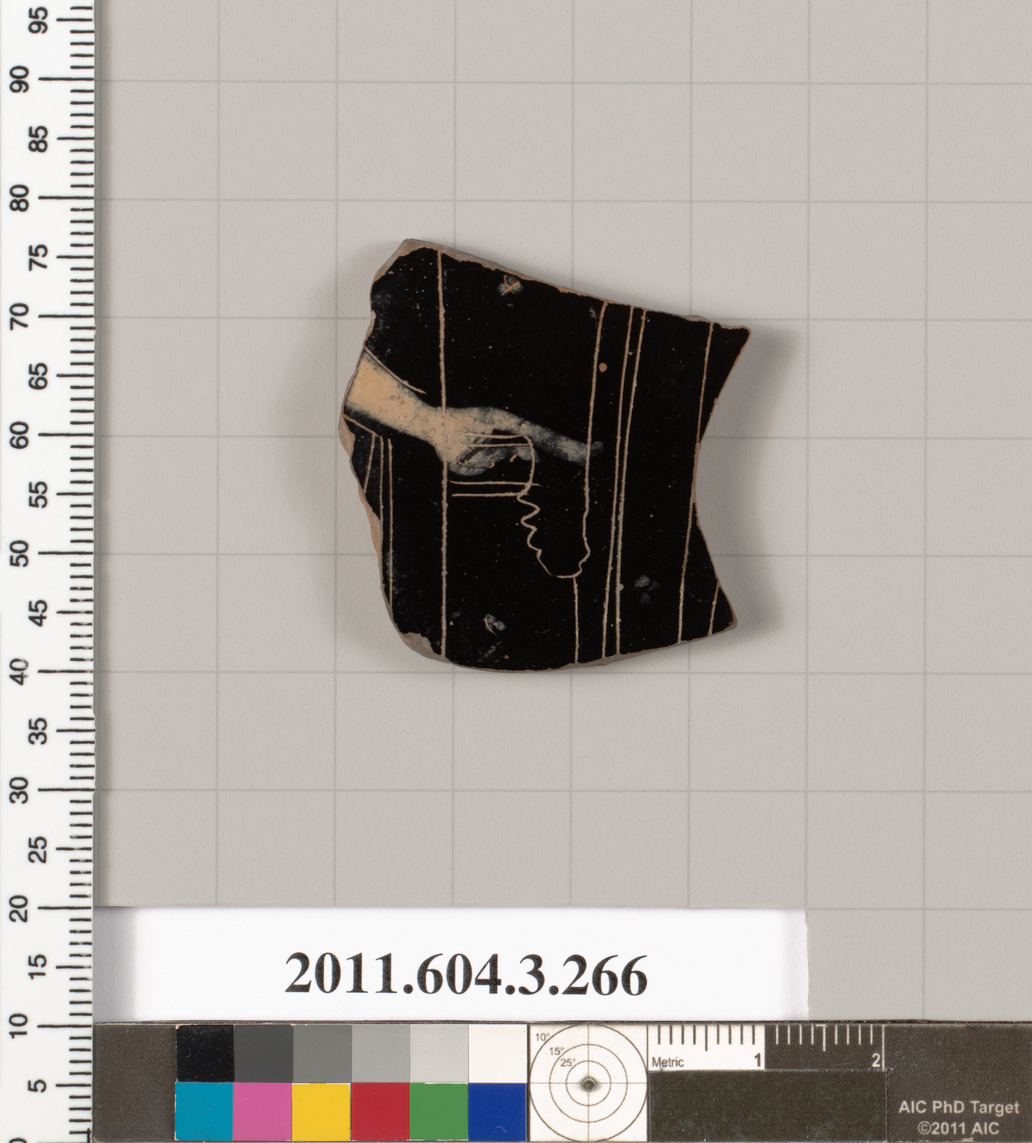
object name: neck amphora fragment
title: Terracotta fragment of a neck-amphora (jar)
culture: greek, attic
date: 525-501 BCE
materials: terracotta